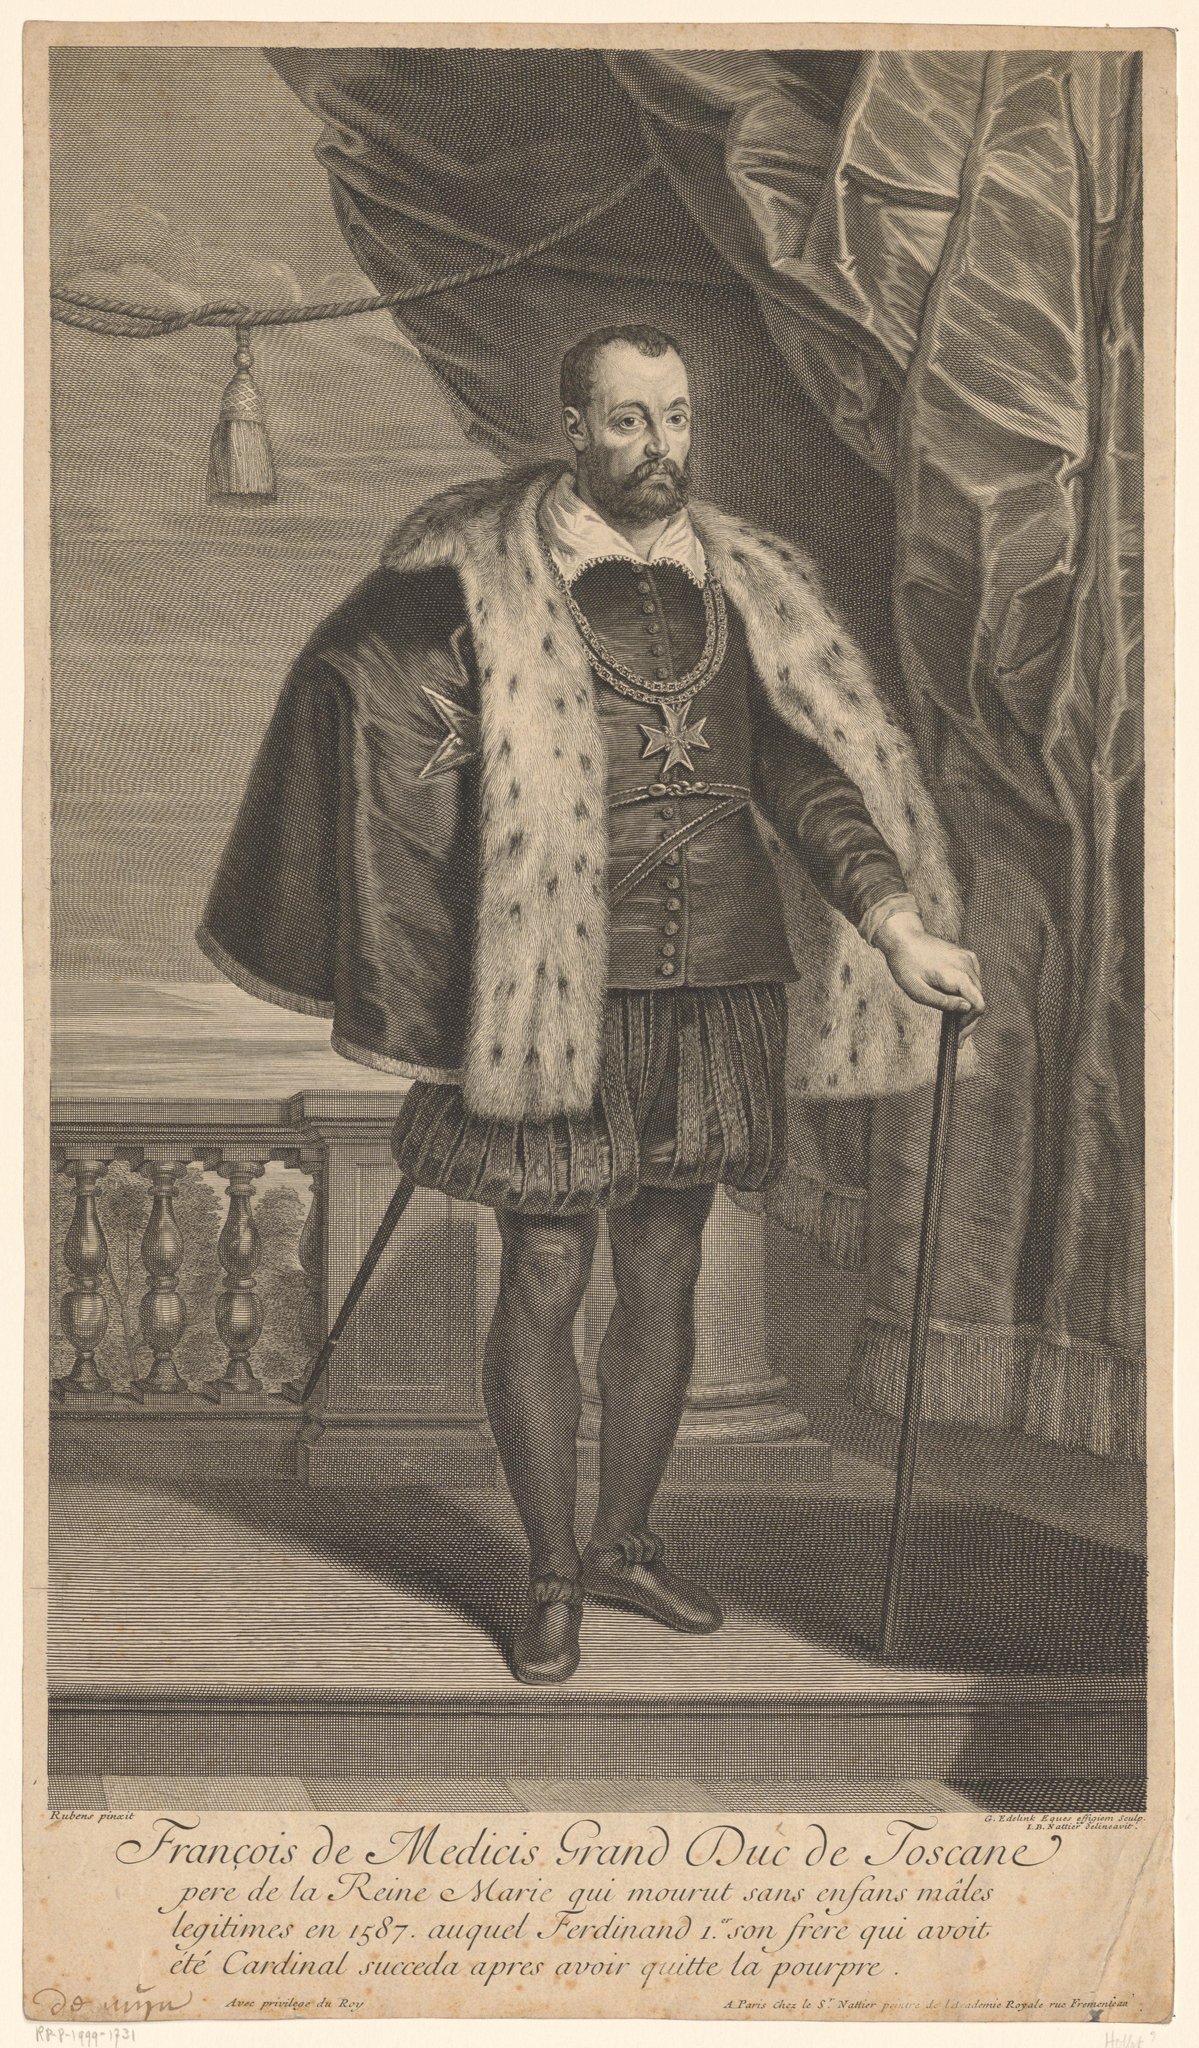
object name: print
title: François de Medicis Grand Duc de Toscane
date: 1688-1707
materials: paper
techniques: engraving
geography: france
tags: francesco i de' medici, historical persons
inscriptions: collector's mark: Lugt 2760, collector's mark: Lugt 2228